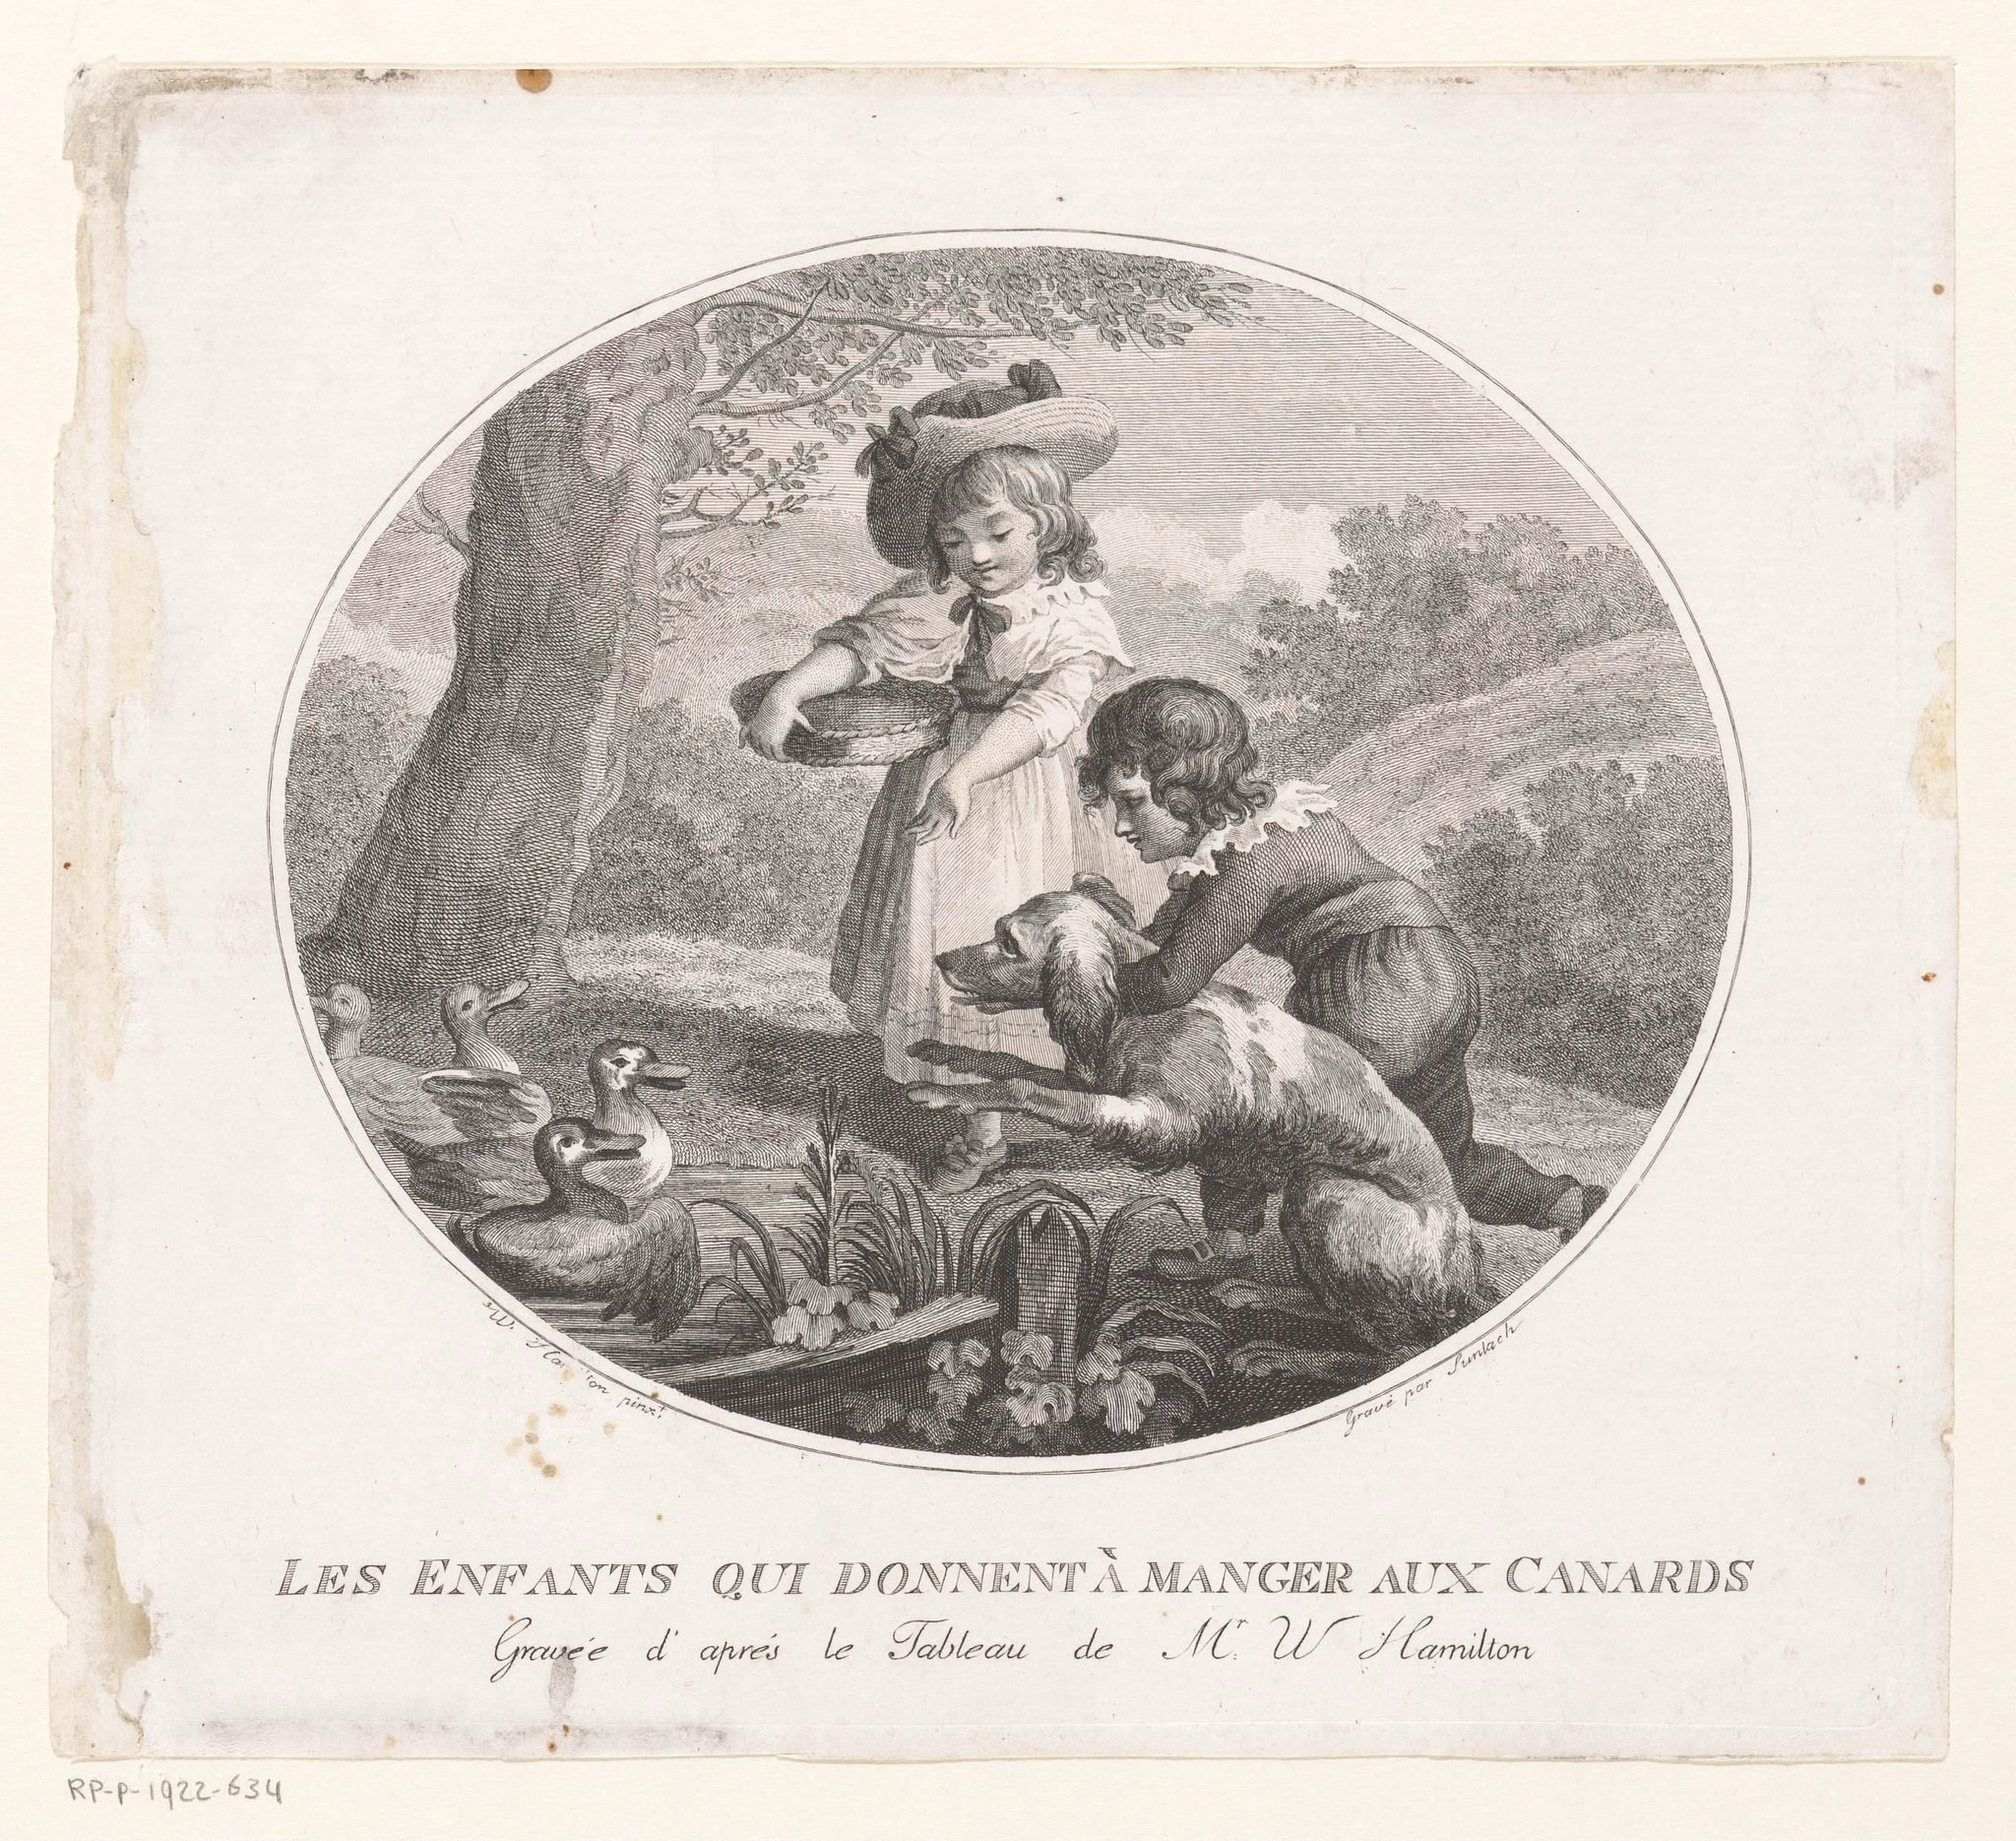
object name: print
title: Kinderspelen naar schilderijen van William Hamilton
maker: william hamilton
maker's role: draughtsman, painter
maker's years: 1751-1801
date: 1754-1842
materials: paper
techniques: engraving, etching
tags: water-birds: duck, dog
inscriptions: collector's mark: Lugt 2228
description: Een meisje, een jongen en een hond staan aan de rand van een vijver terwijl zij eenden voeren.